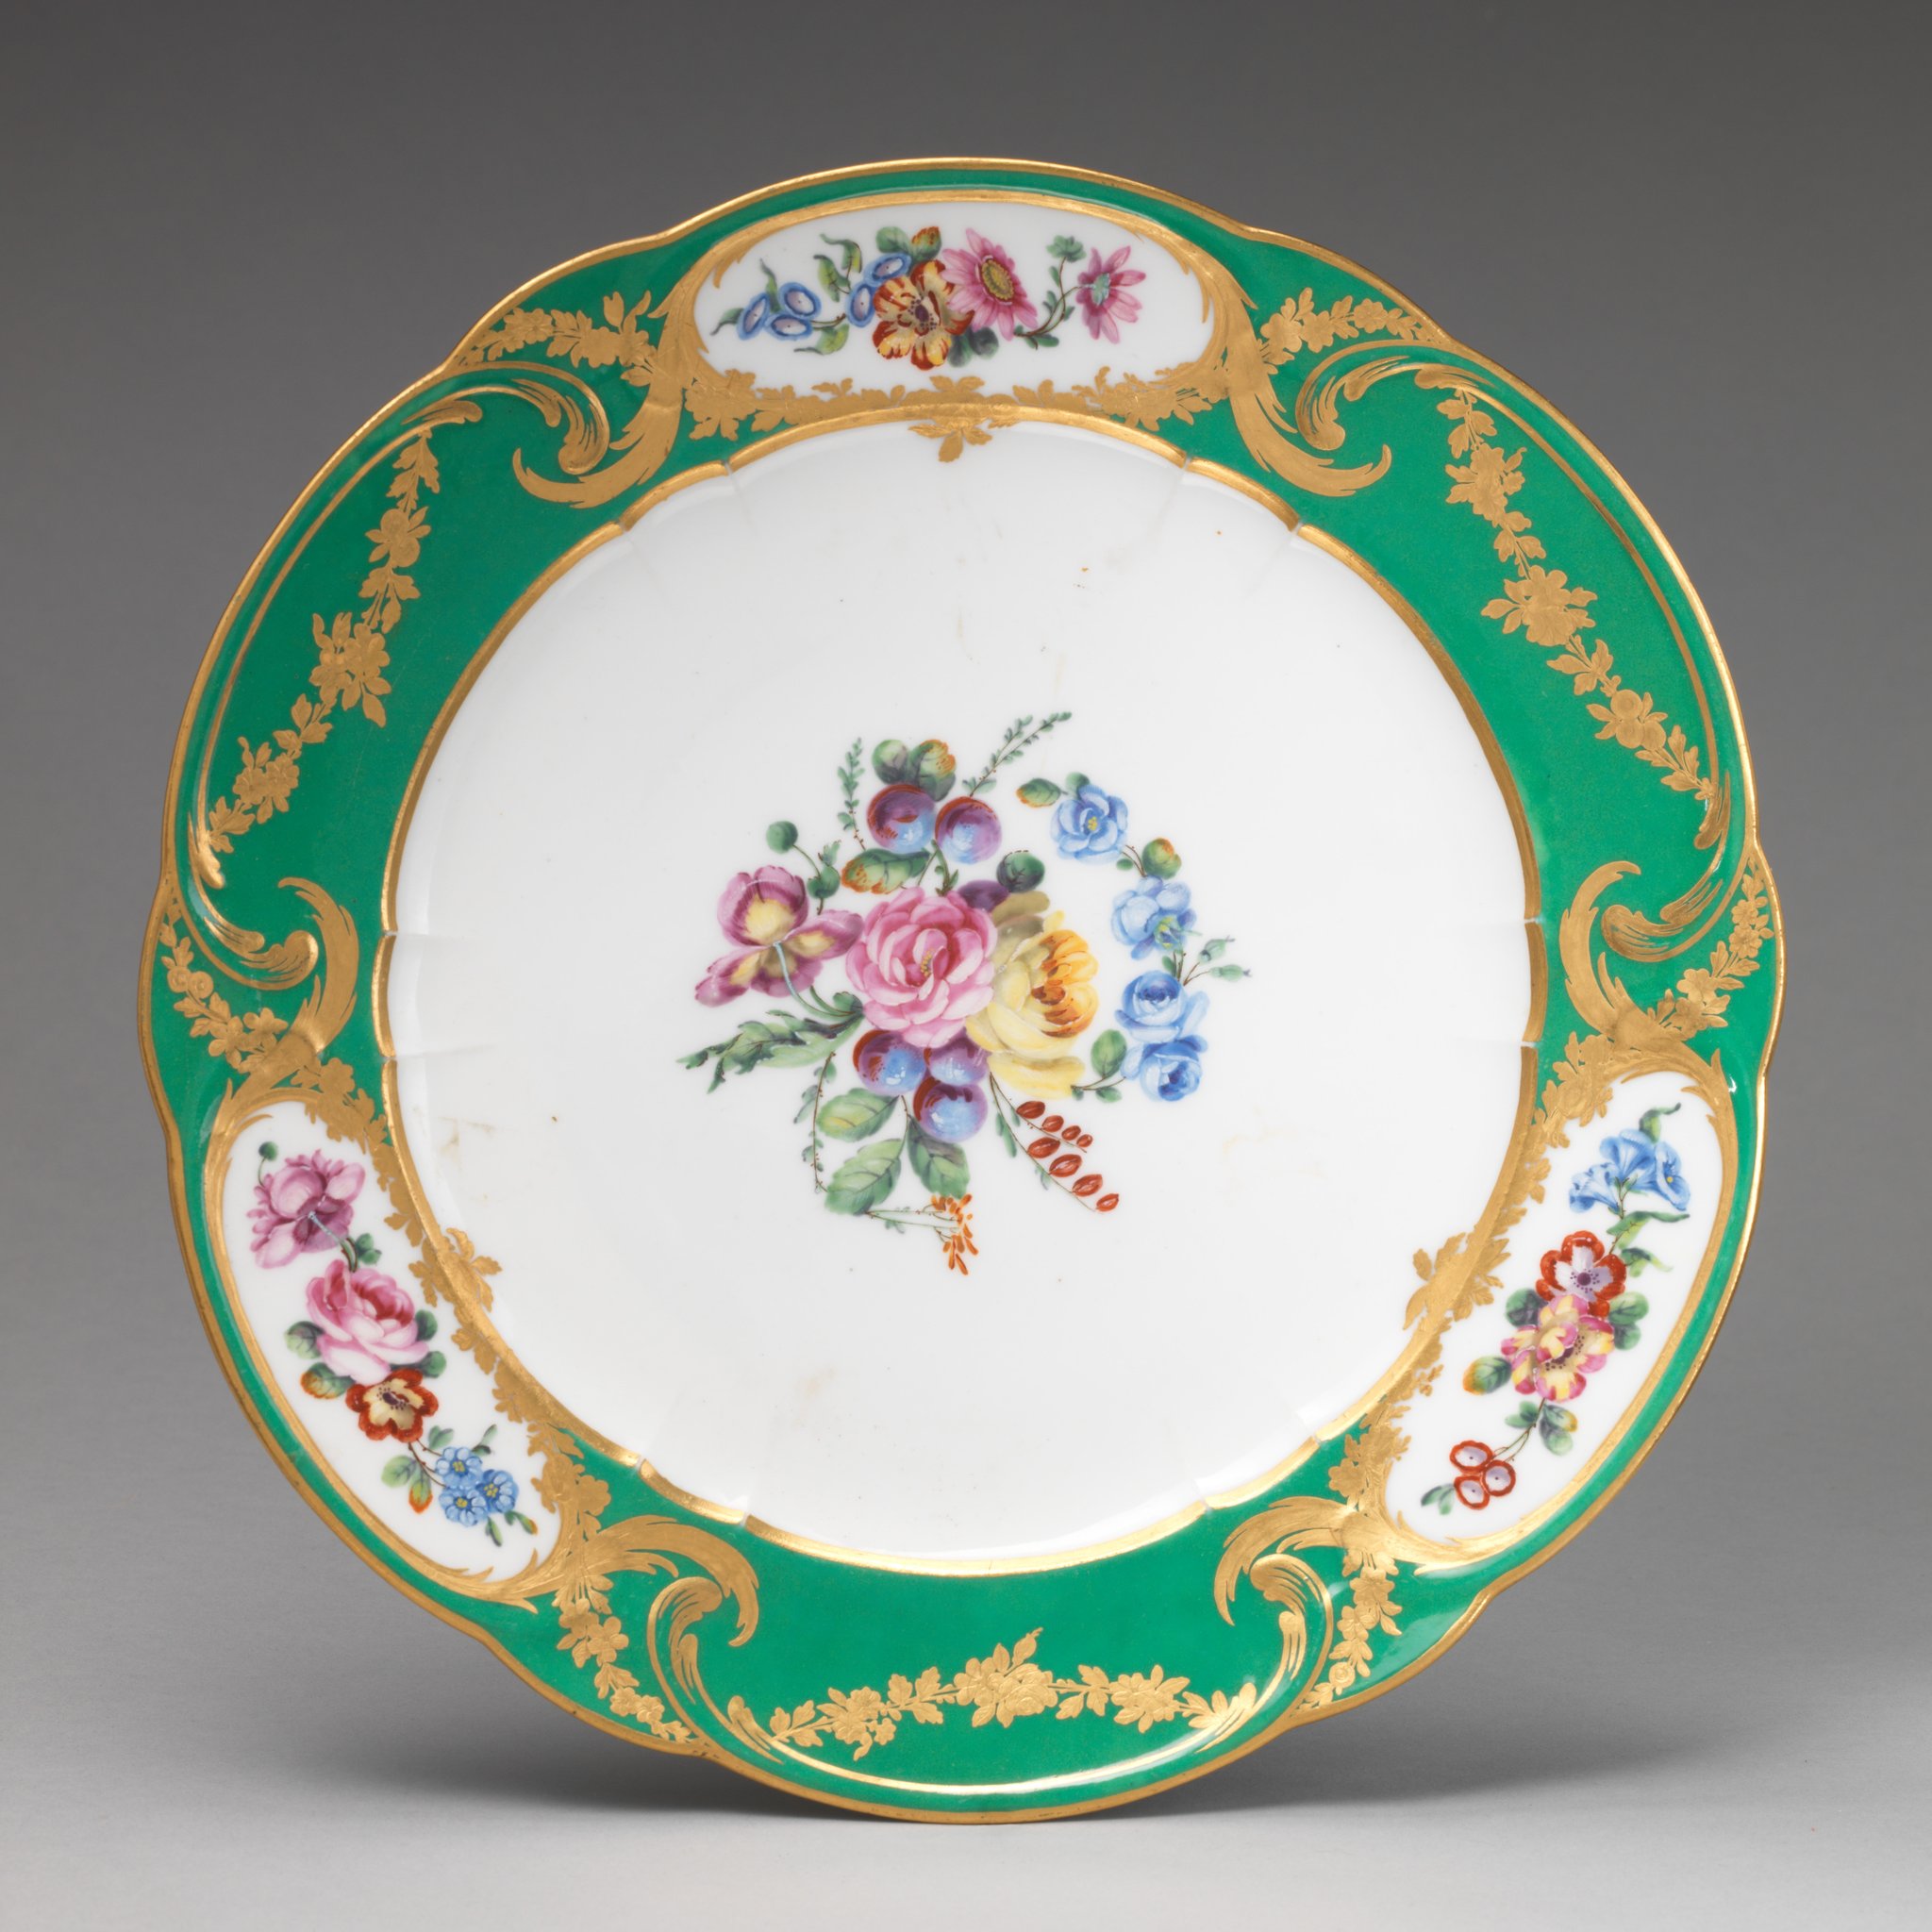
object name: plate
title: Plate (part of a service)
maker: sèvres manufactory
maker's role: manufactory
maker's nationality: french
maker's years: 1740-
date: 1772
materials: soft paste porcelain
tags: flowers